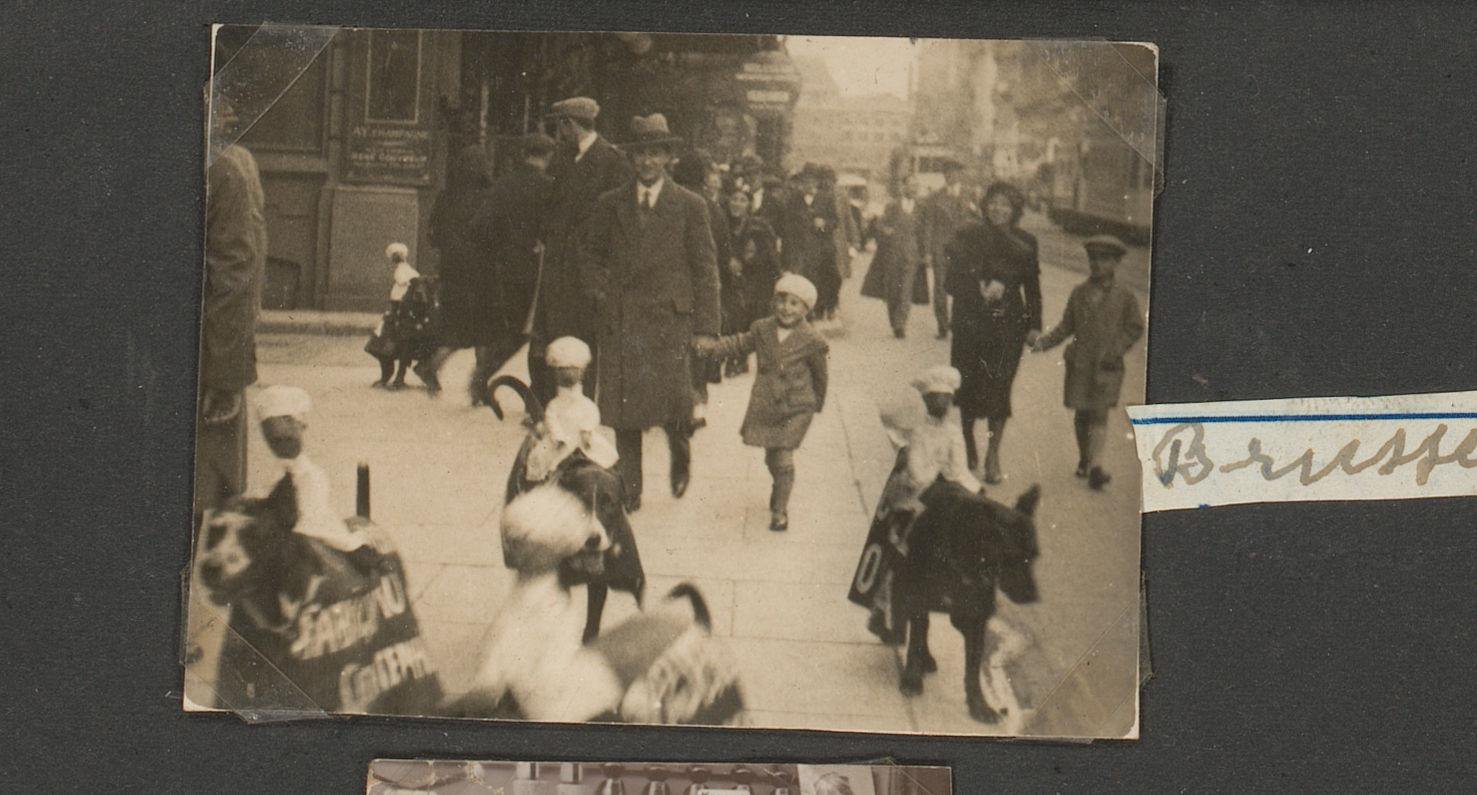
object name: album leaf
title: De poppendokter met kind aan de hand en honden met reclameteksten en banketbakkerspoppen op de rug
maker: Anonymous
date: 1930-1940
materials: photographic support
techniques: gelatin silver print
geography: brussels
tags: advertising, dolls for adults, adult man, child, dog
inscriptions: annotation: ‘Brussel’